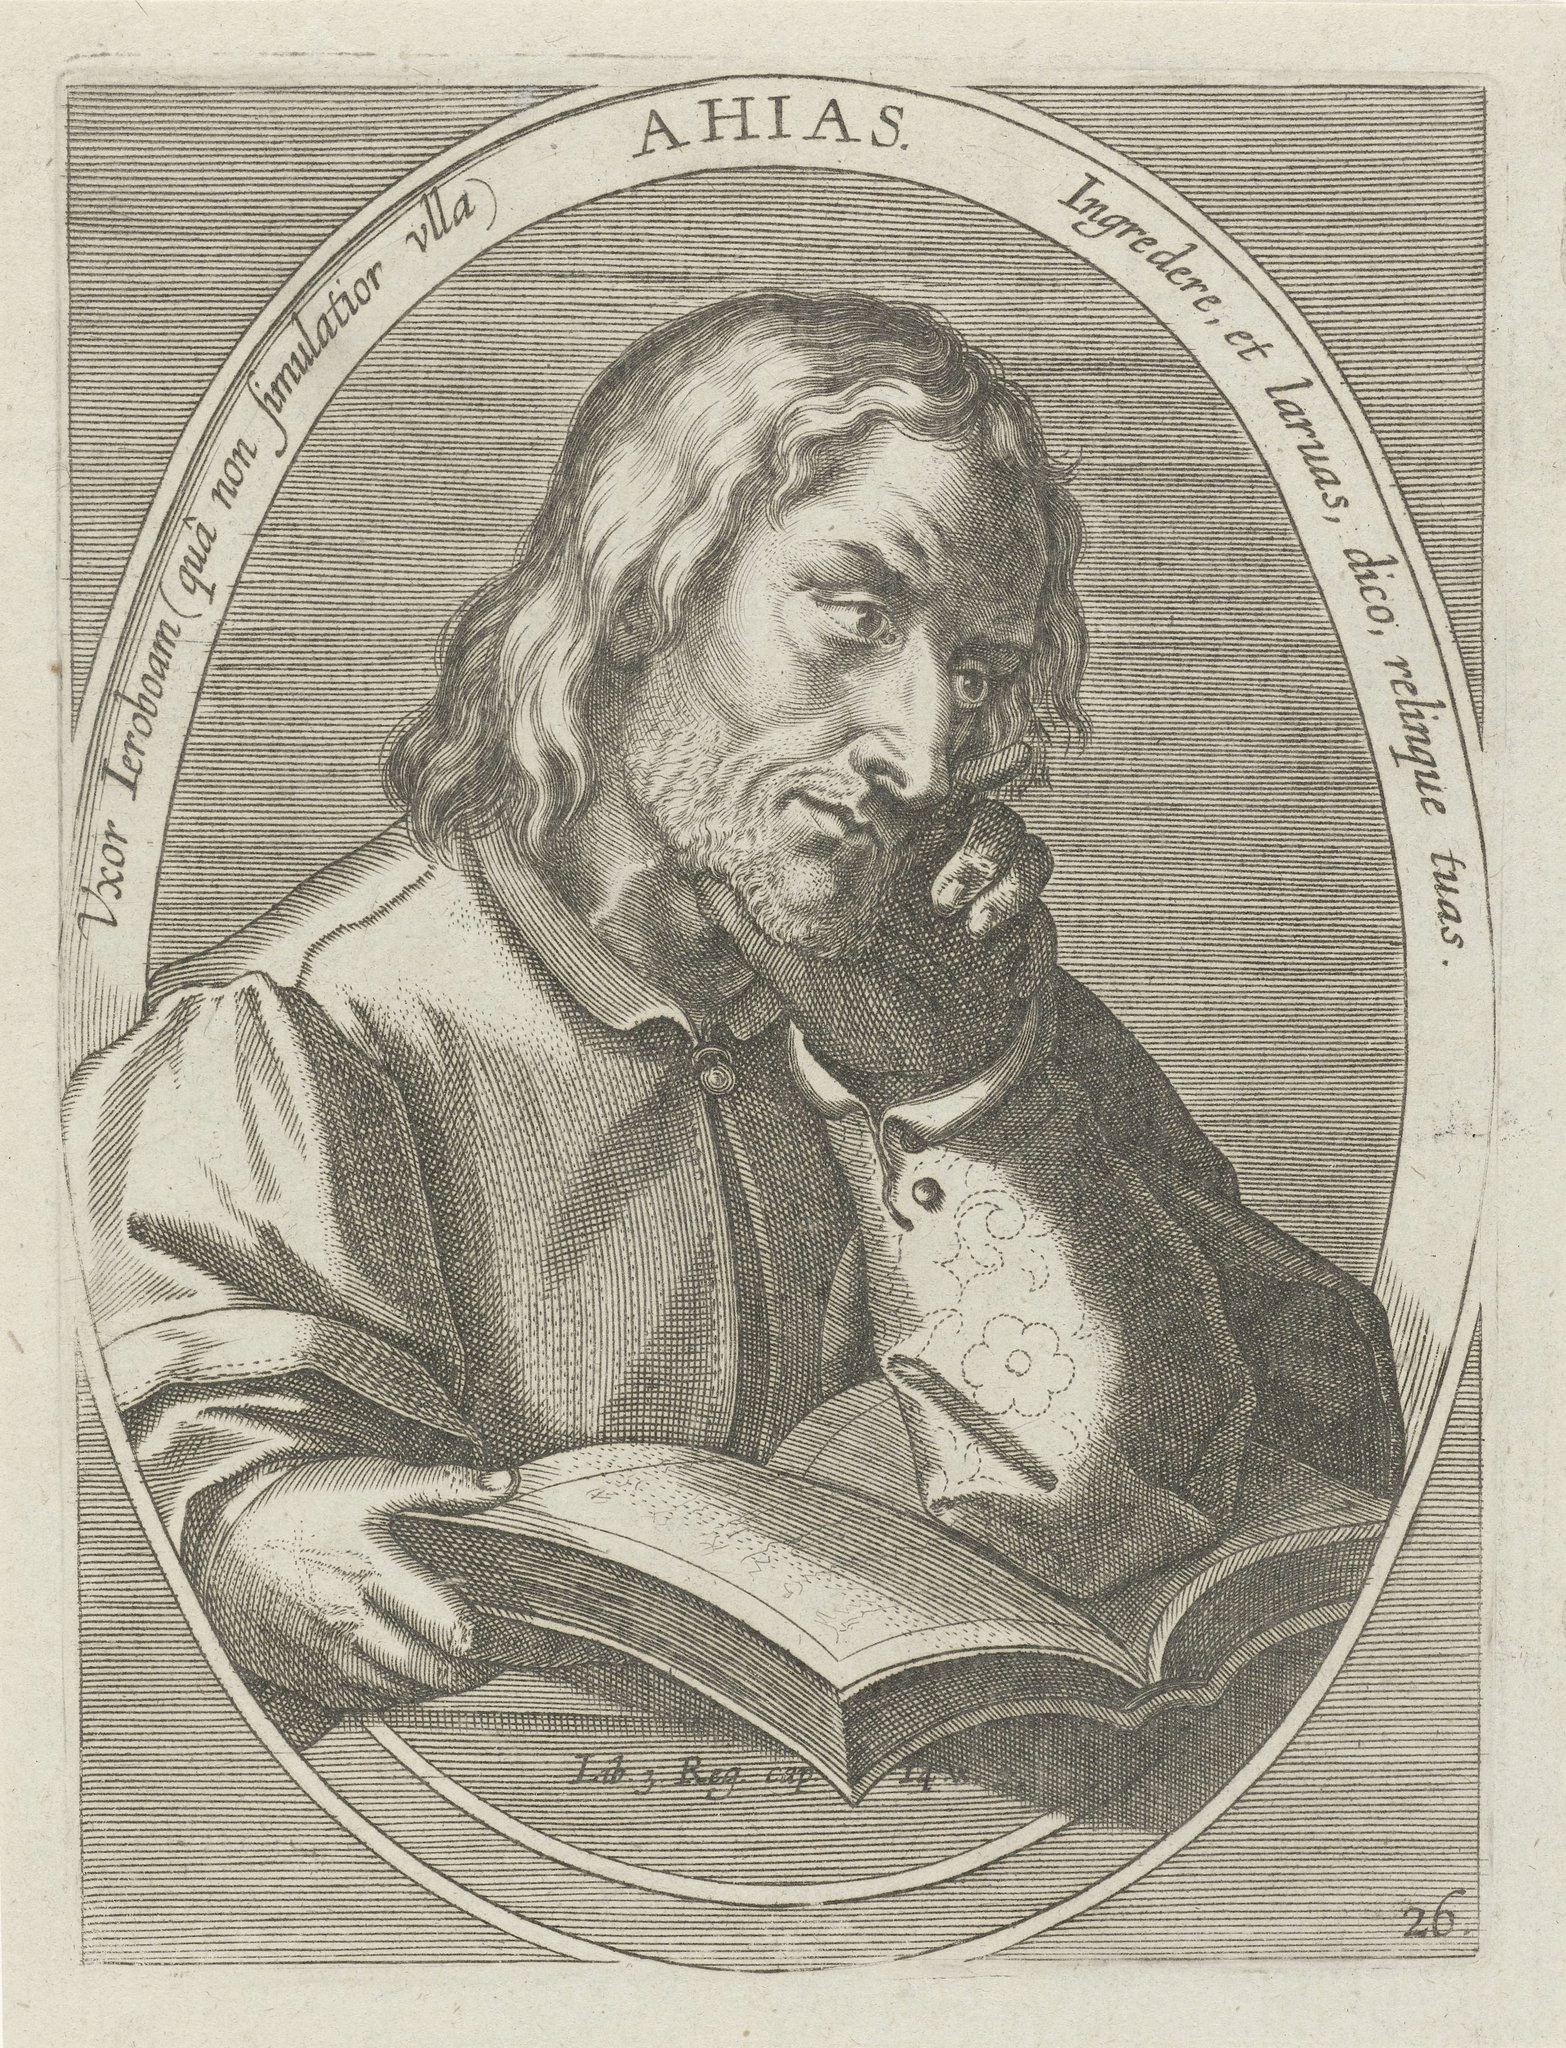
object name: print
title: Icones Prophetarum Veteris Testamenti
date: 1613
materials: paper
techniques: engraving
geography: antwerp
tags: (single) prophet, unspecified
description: De profeet Ahias mijmerend boven een boek, in ovaal met Latijns randschrift.